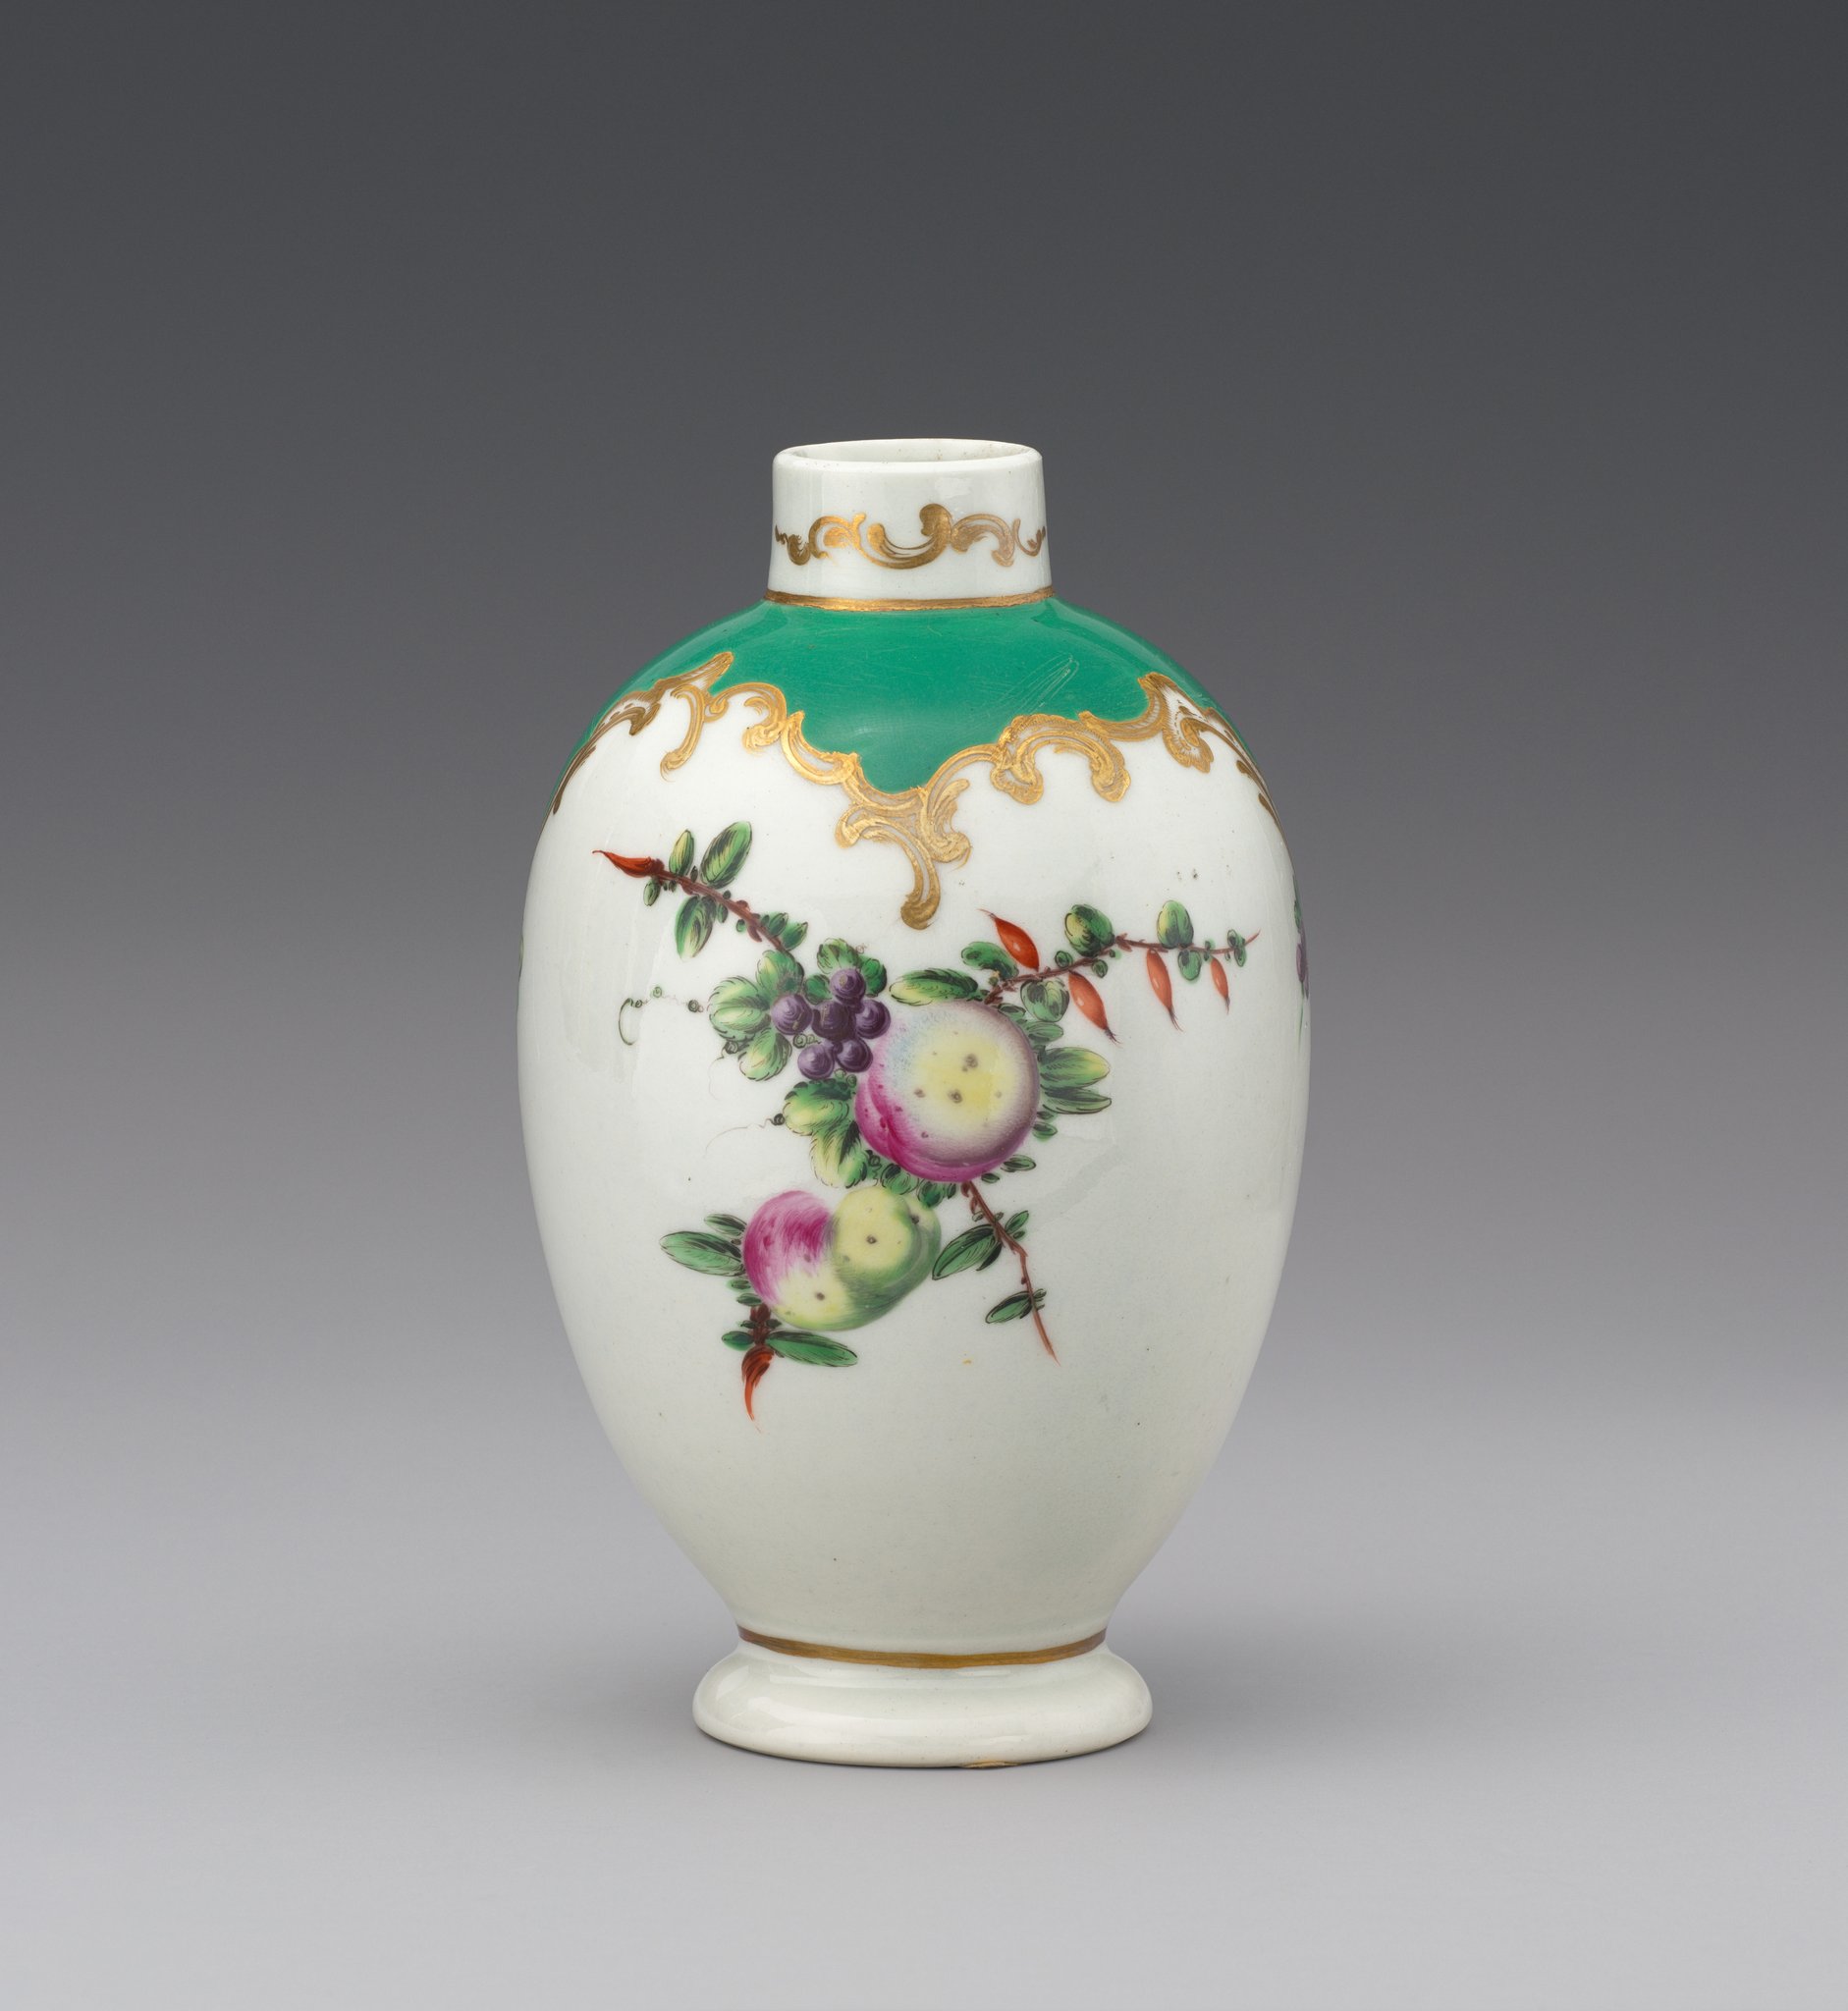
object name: tea caddy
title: Tea caddy (part of a service)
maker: worcester factory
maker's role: factory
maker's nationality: british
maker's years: 1751-2008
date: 1770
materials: soft paste porcelain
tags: fruit